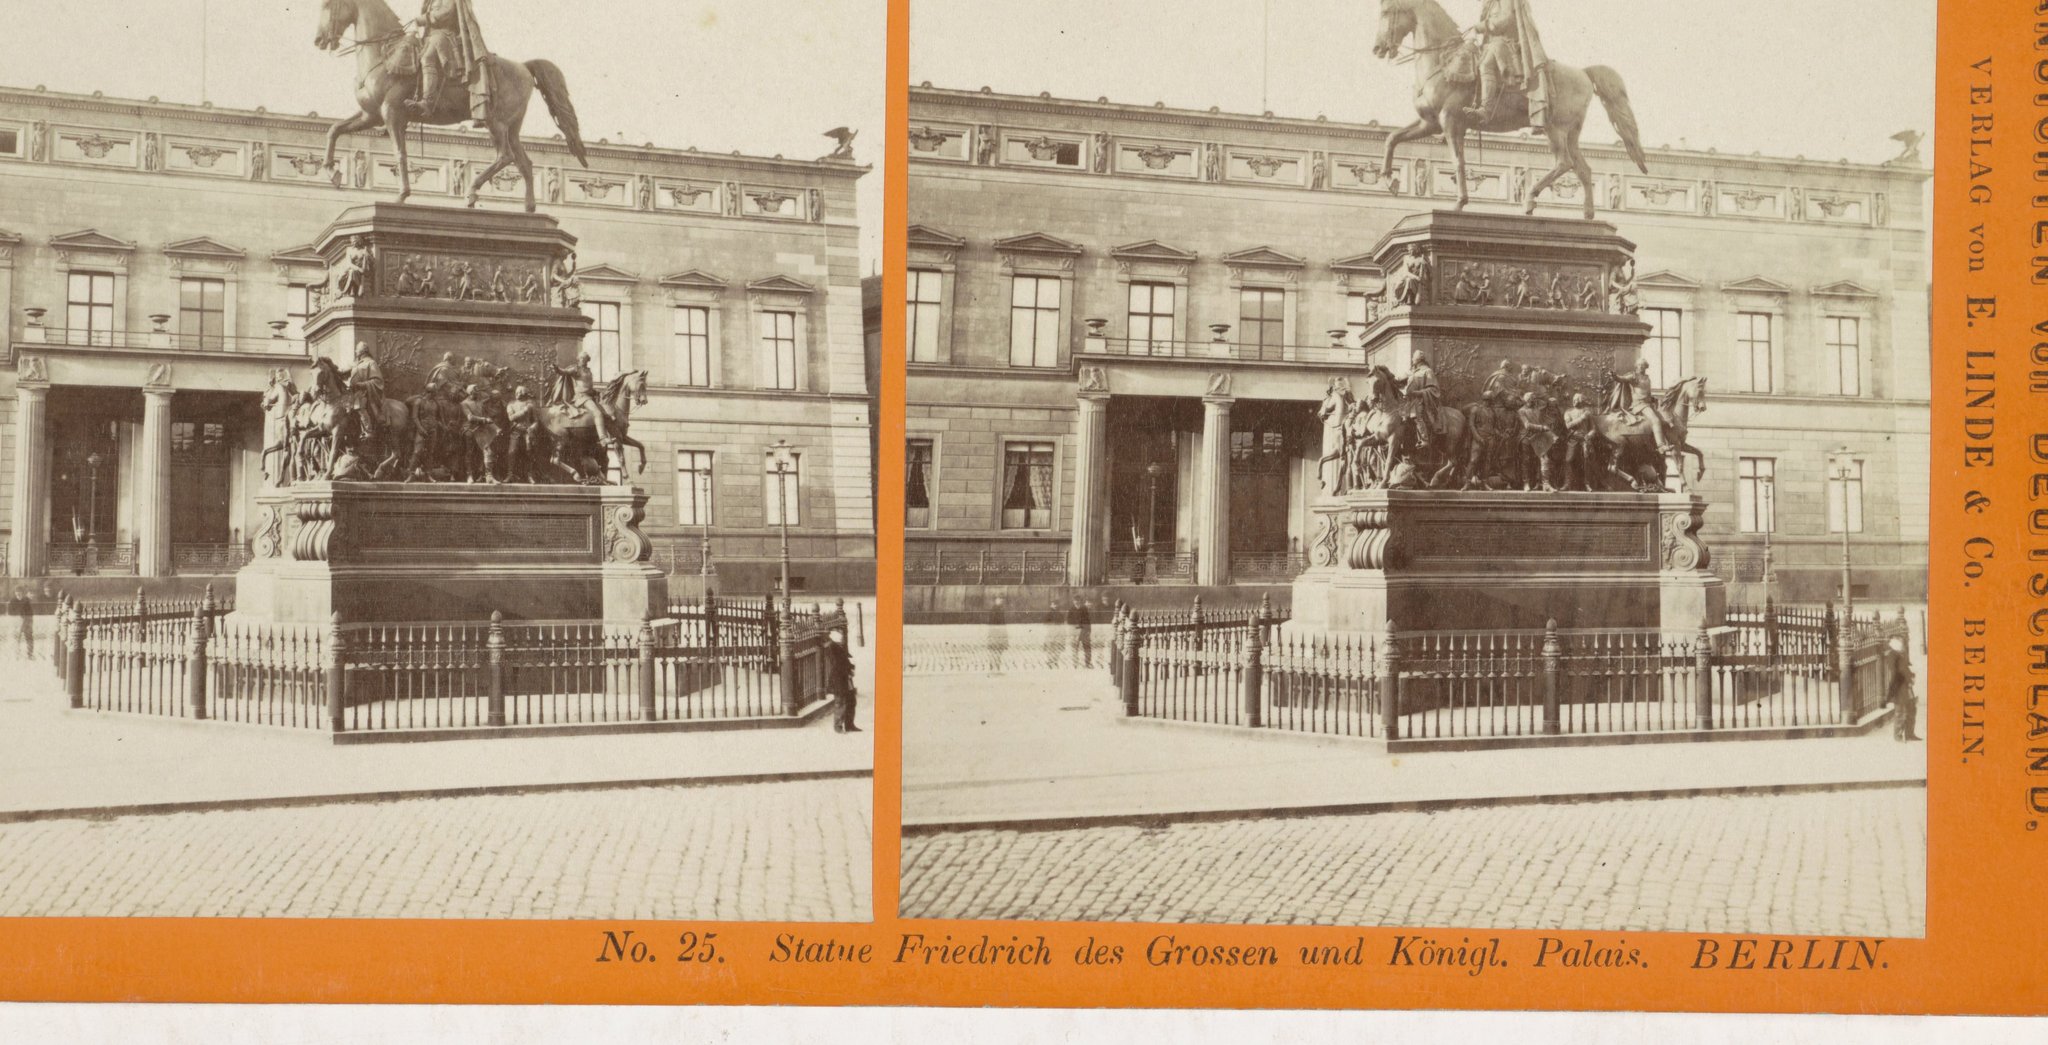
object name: stereograph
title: Ruiterstandbeeld van Frederik de Grote, Unter den Linden, Berlijn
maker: johann friedrich stiehm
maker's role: fotograaf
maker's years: 1826-1902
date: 1868-1870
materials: cardboard, paper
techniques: albumen print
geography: berlin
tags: berlin, frederick ii (king of prussia), monument, statue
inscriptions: number: ‘No. 25.’